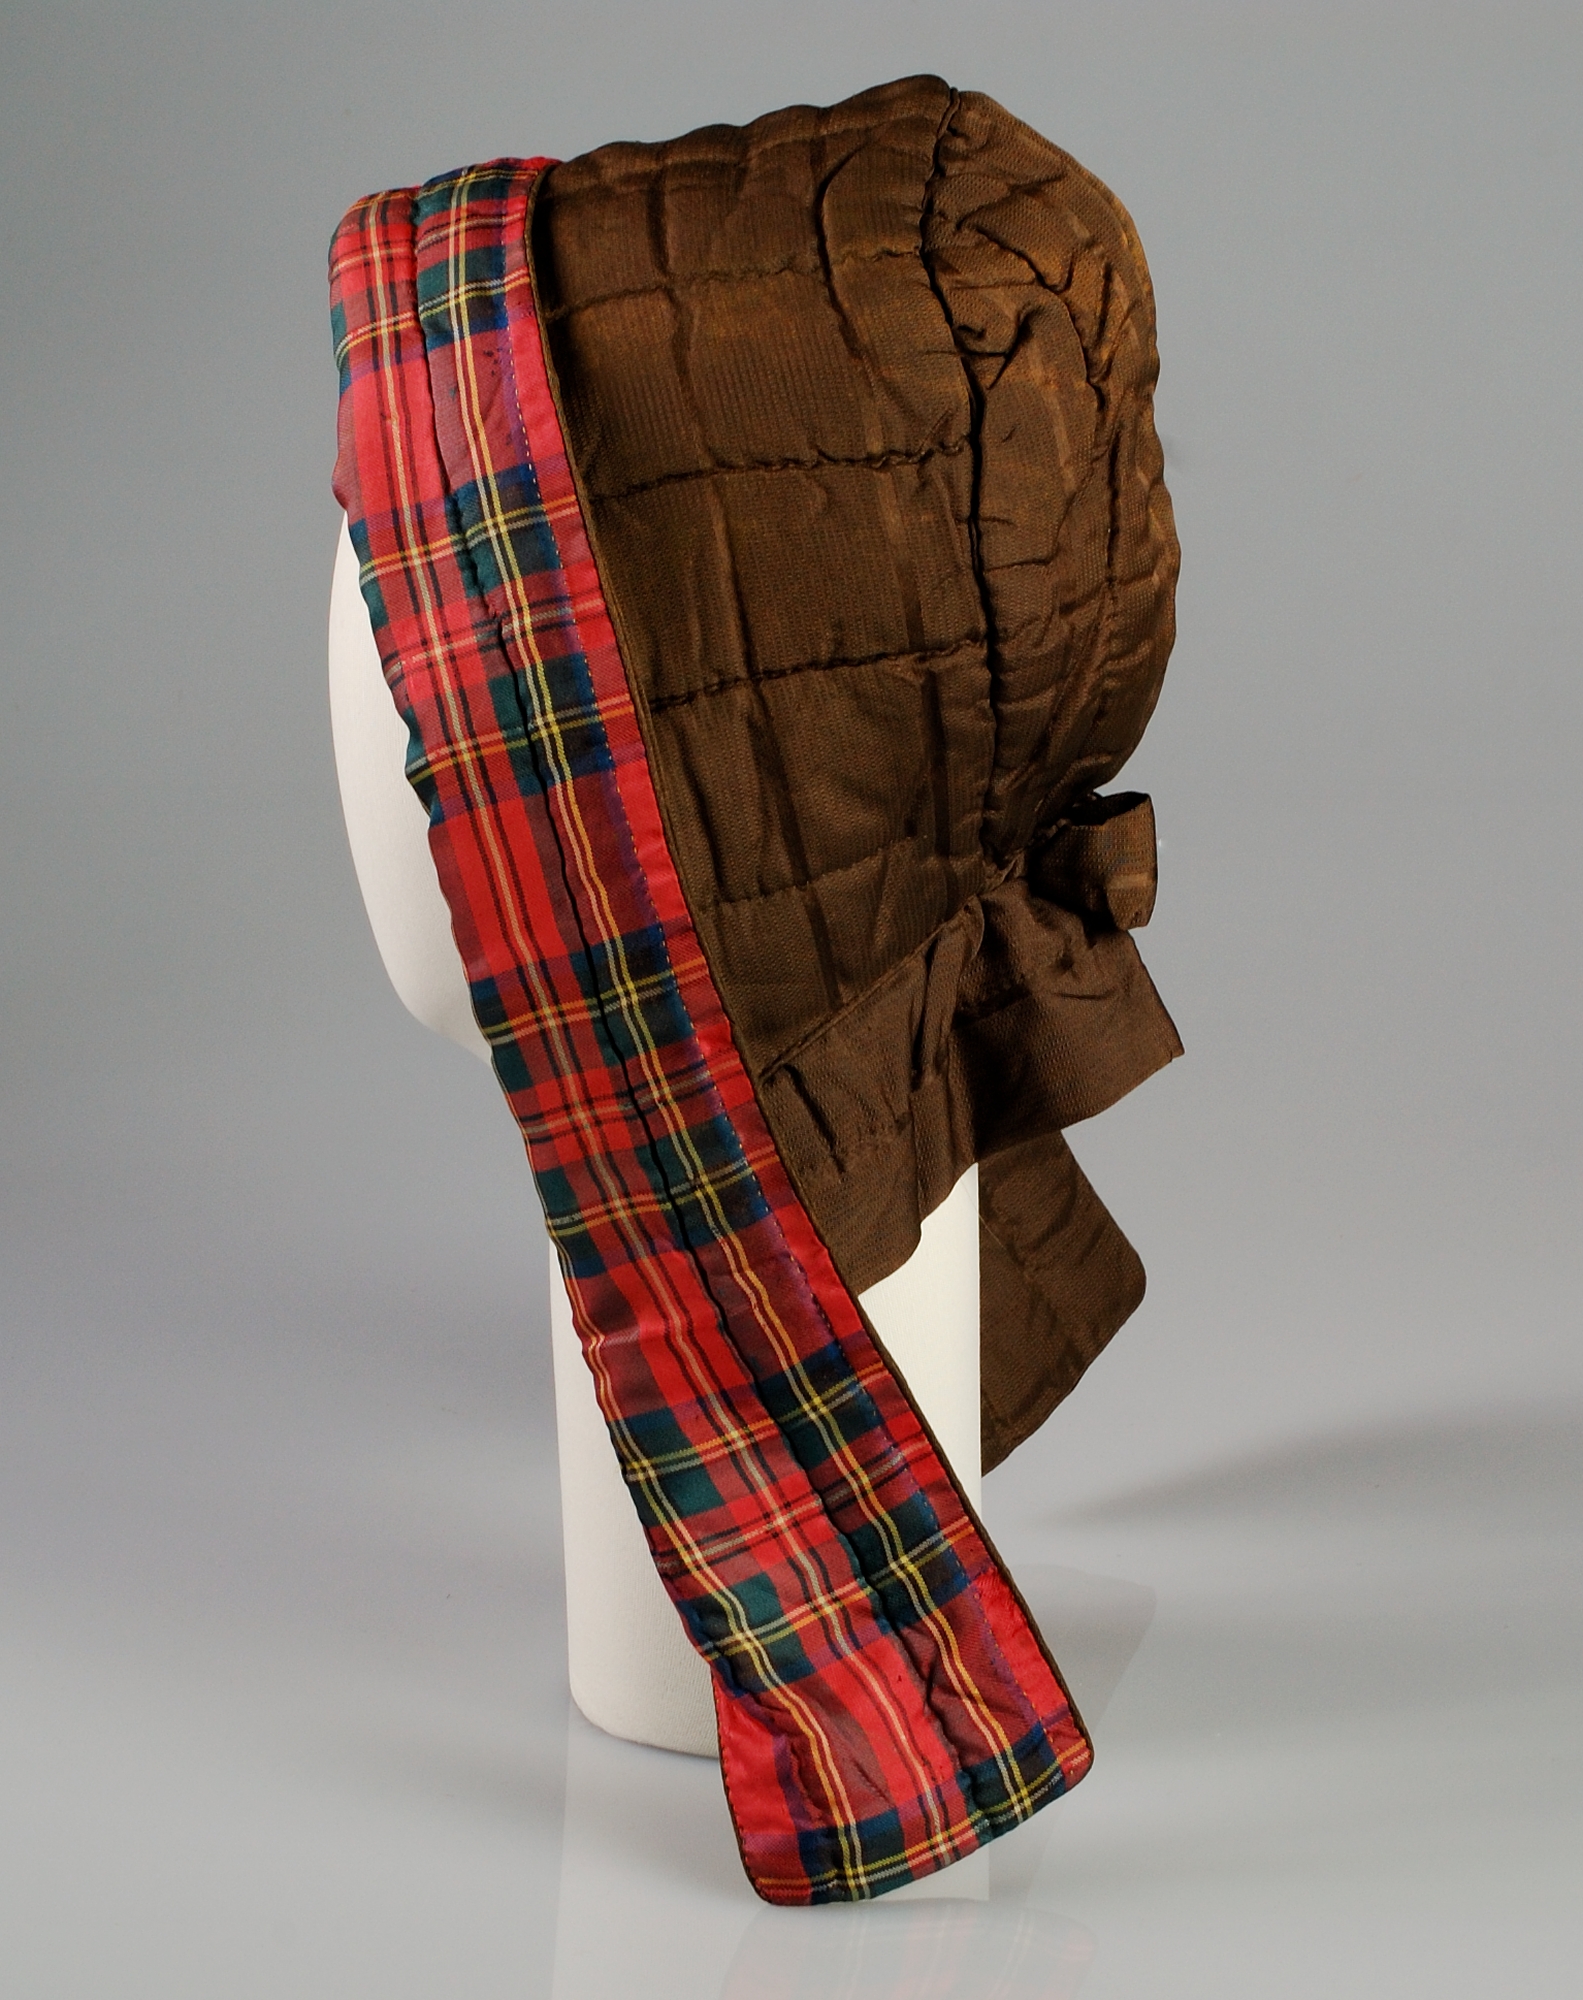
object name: bonnet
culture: american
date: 1845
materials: silk